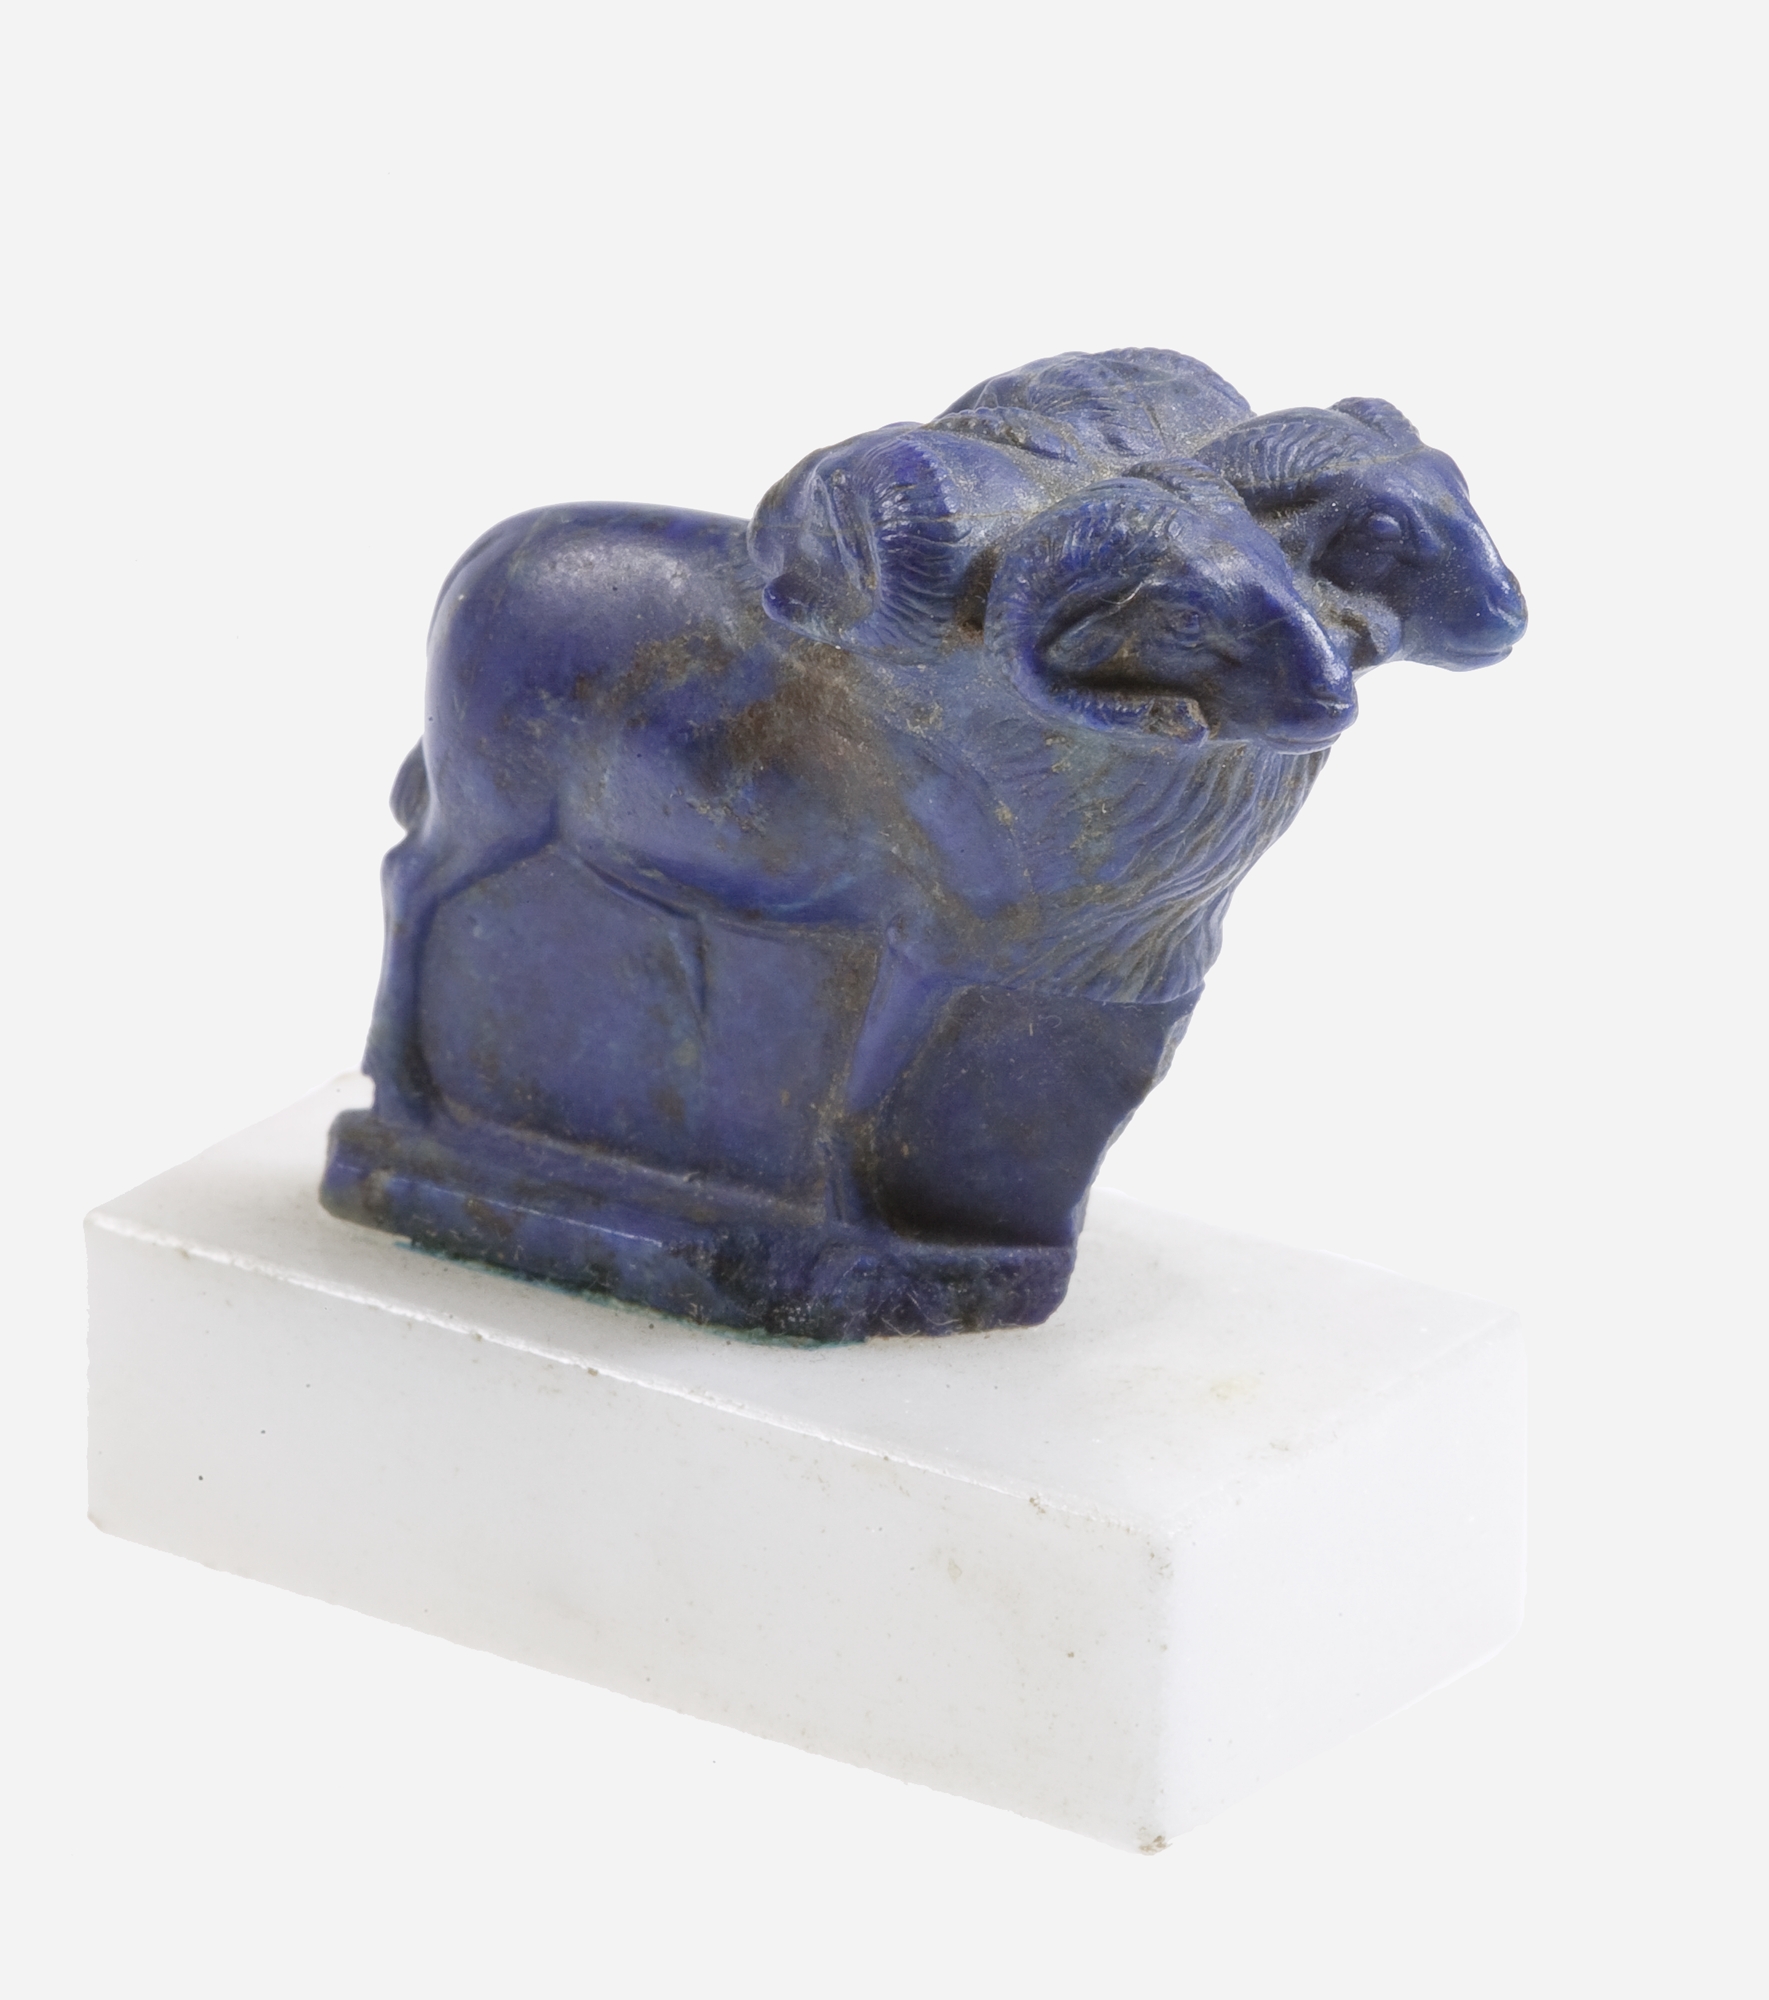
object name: amulet, banebdjedet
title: Banebdjedet, depicted with four ram heads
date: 664-332 BCE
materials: lapis lazuli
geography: egypt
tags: rams